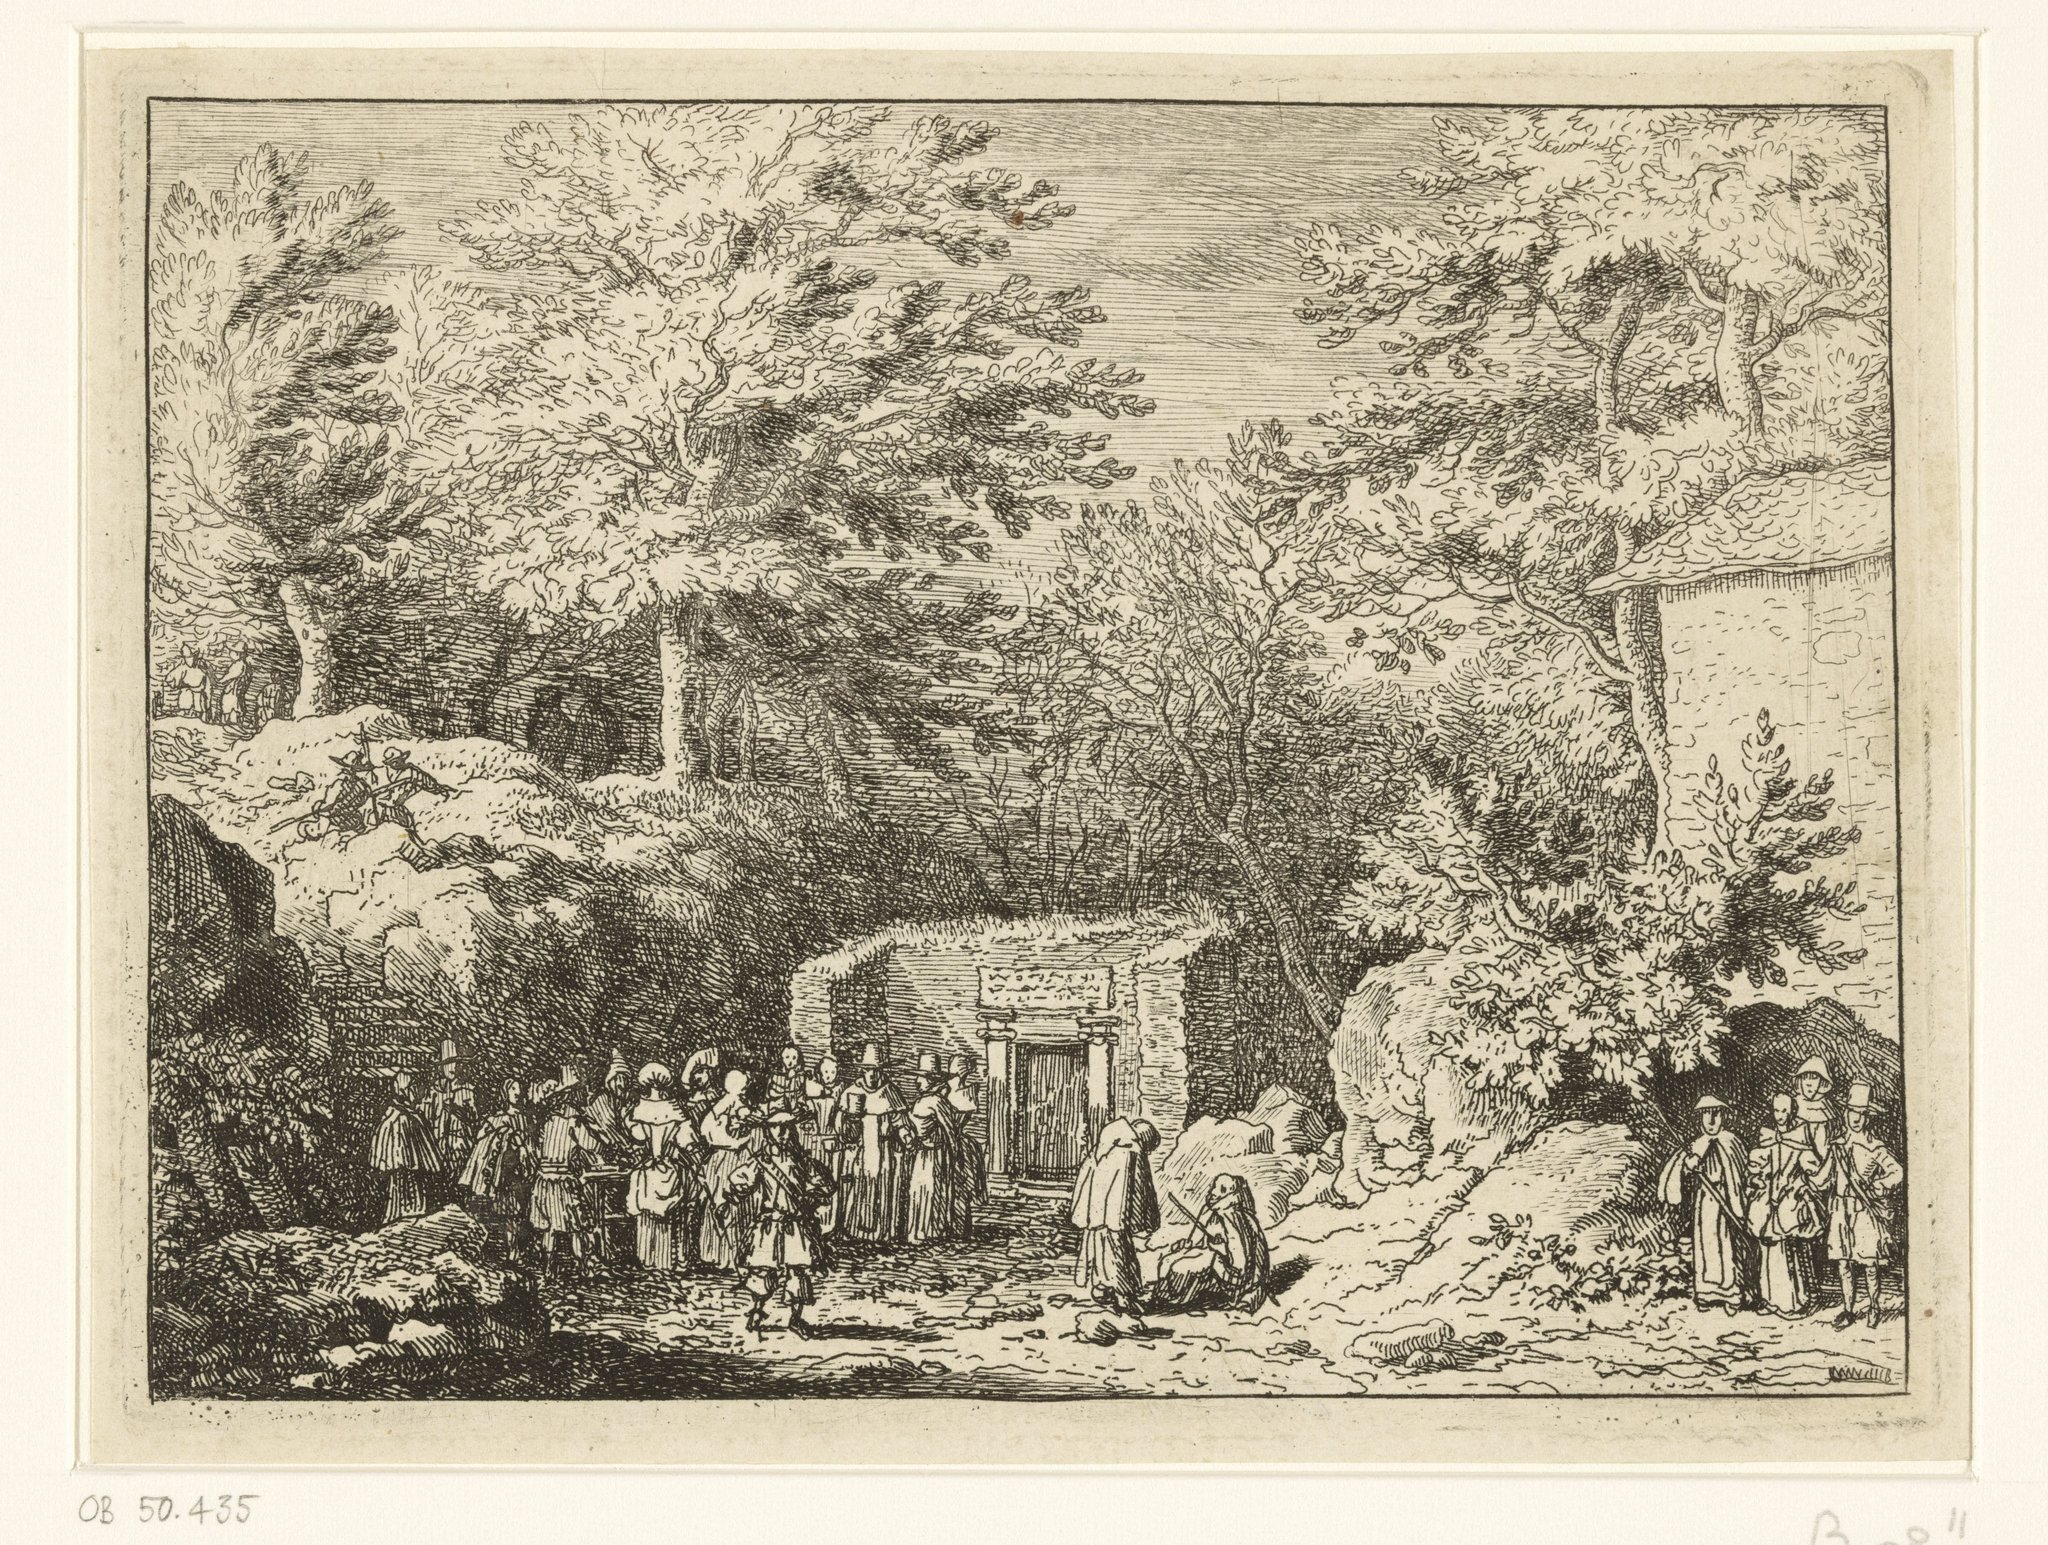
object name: print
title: Vier waterbronnen in en rond Spa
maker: allaert van everdingen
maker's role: draughtsman, painter, print maker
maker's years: 1621-1675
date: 1631-1675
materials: paper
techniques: etching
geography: netherlands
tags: spring (fluids extracted from the earth)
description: Bosachtig landschap met aan de voet van een heuvel een groep mensen bij een waterbron.